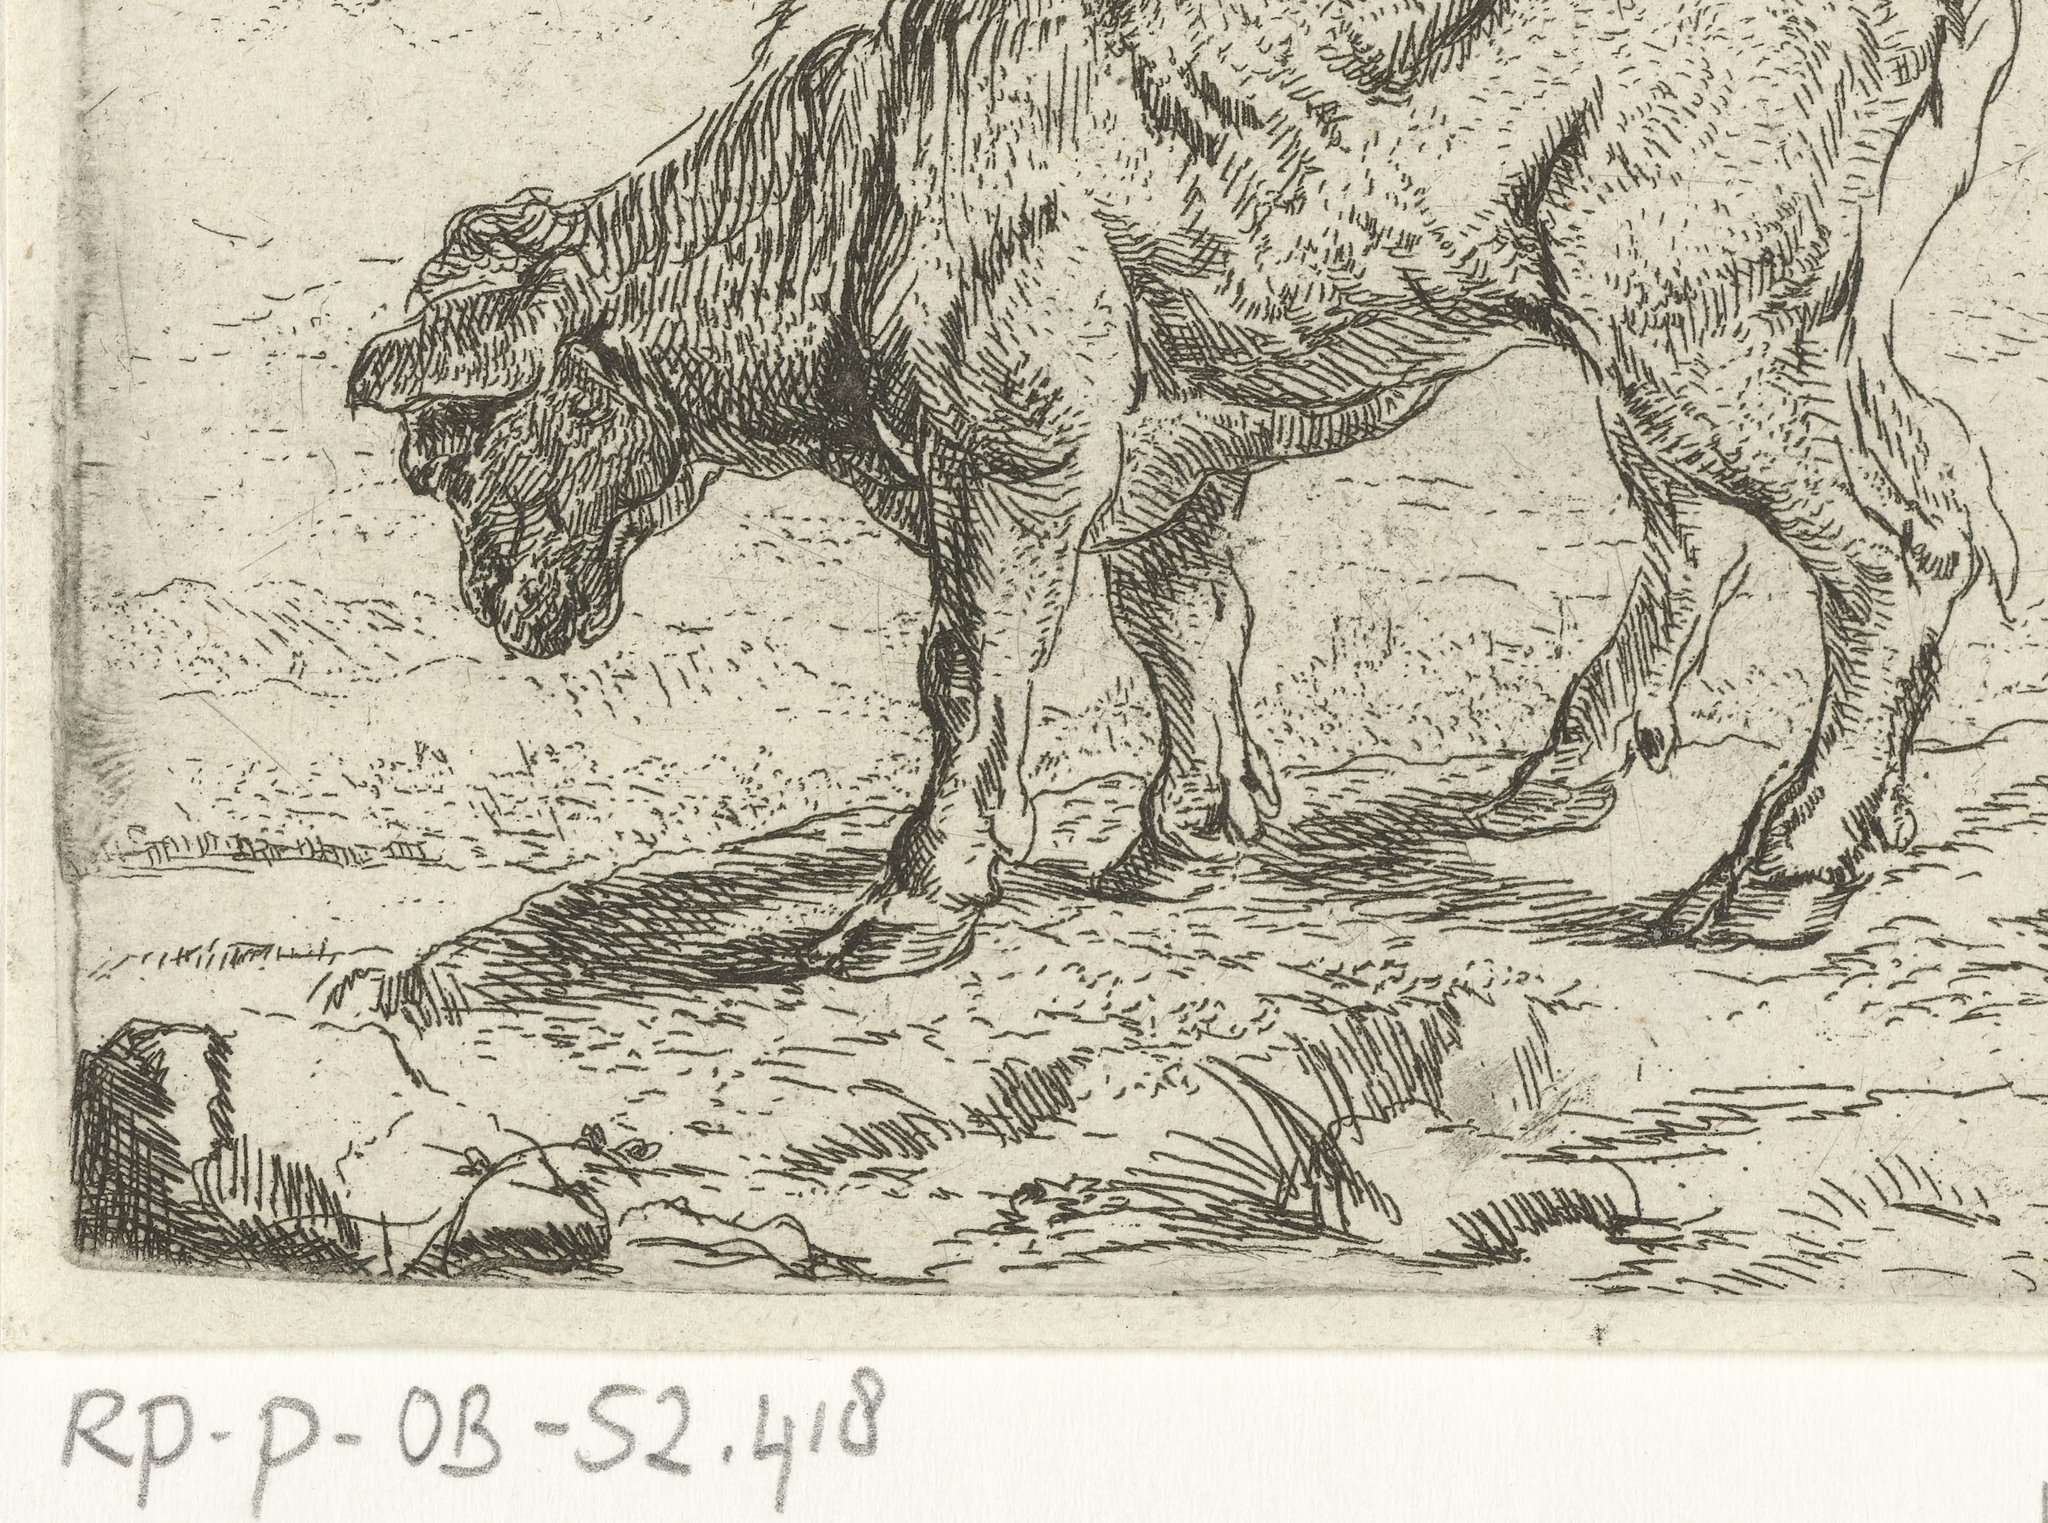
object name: print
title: Dieren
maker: joannes fijt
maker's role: draughtsman, print maker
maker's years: 1611-1661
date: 1621-1661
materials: paper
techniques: etching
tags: calf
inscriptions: collector's mark: Lugt 2228